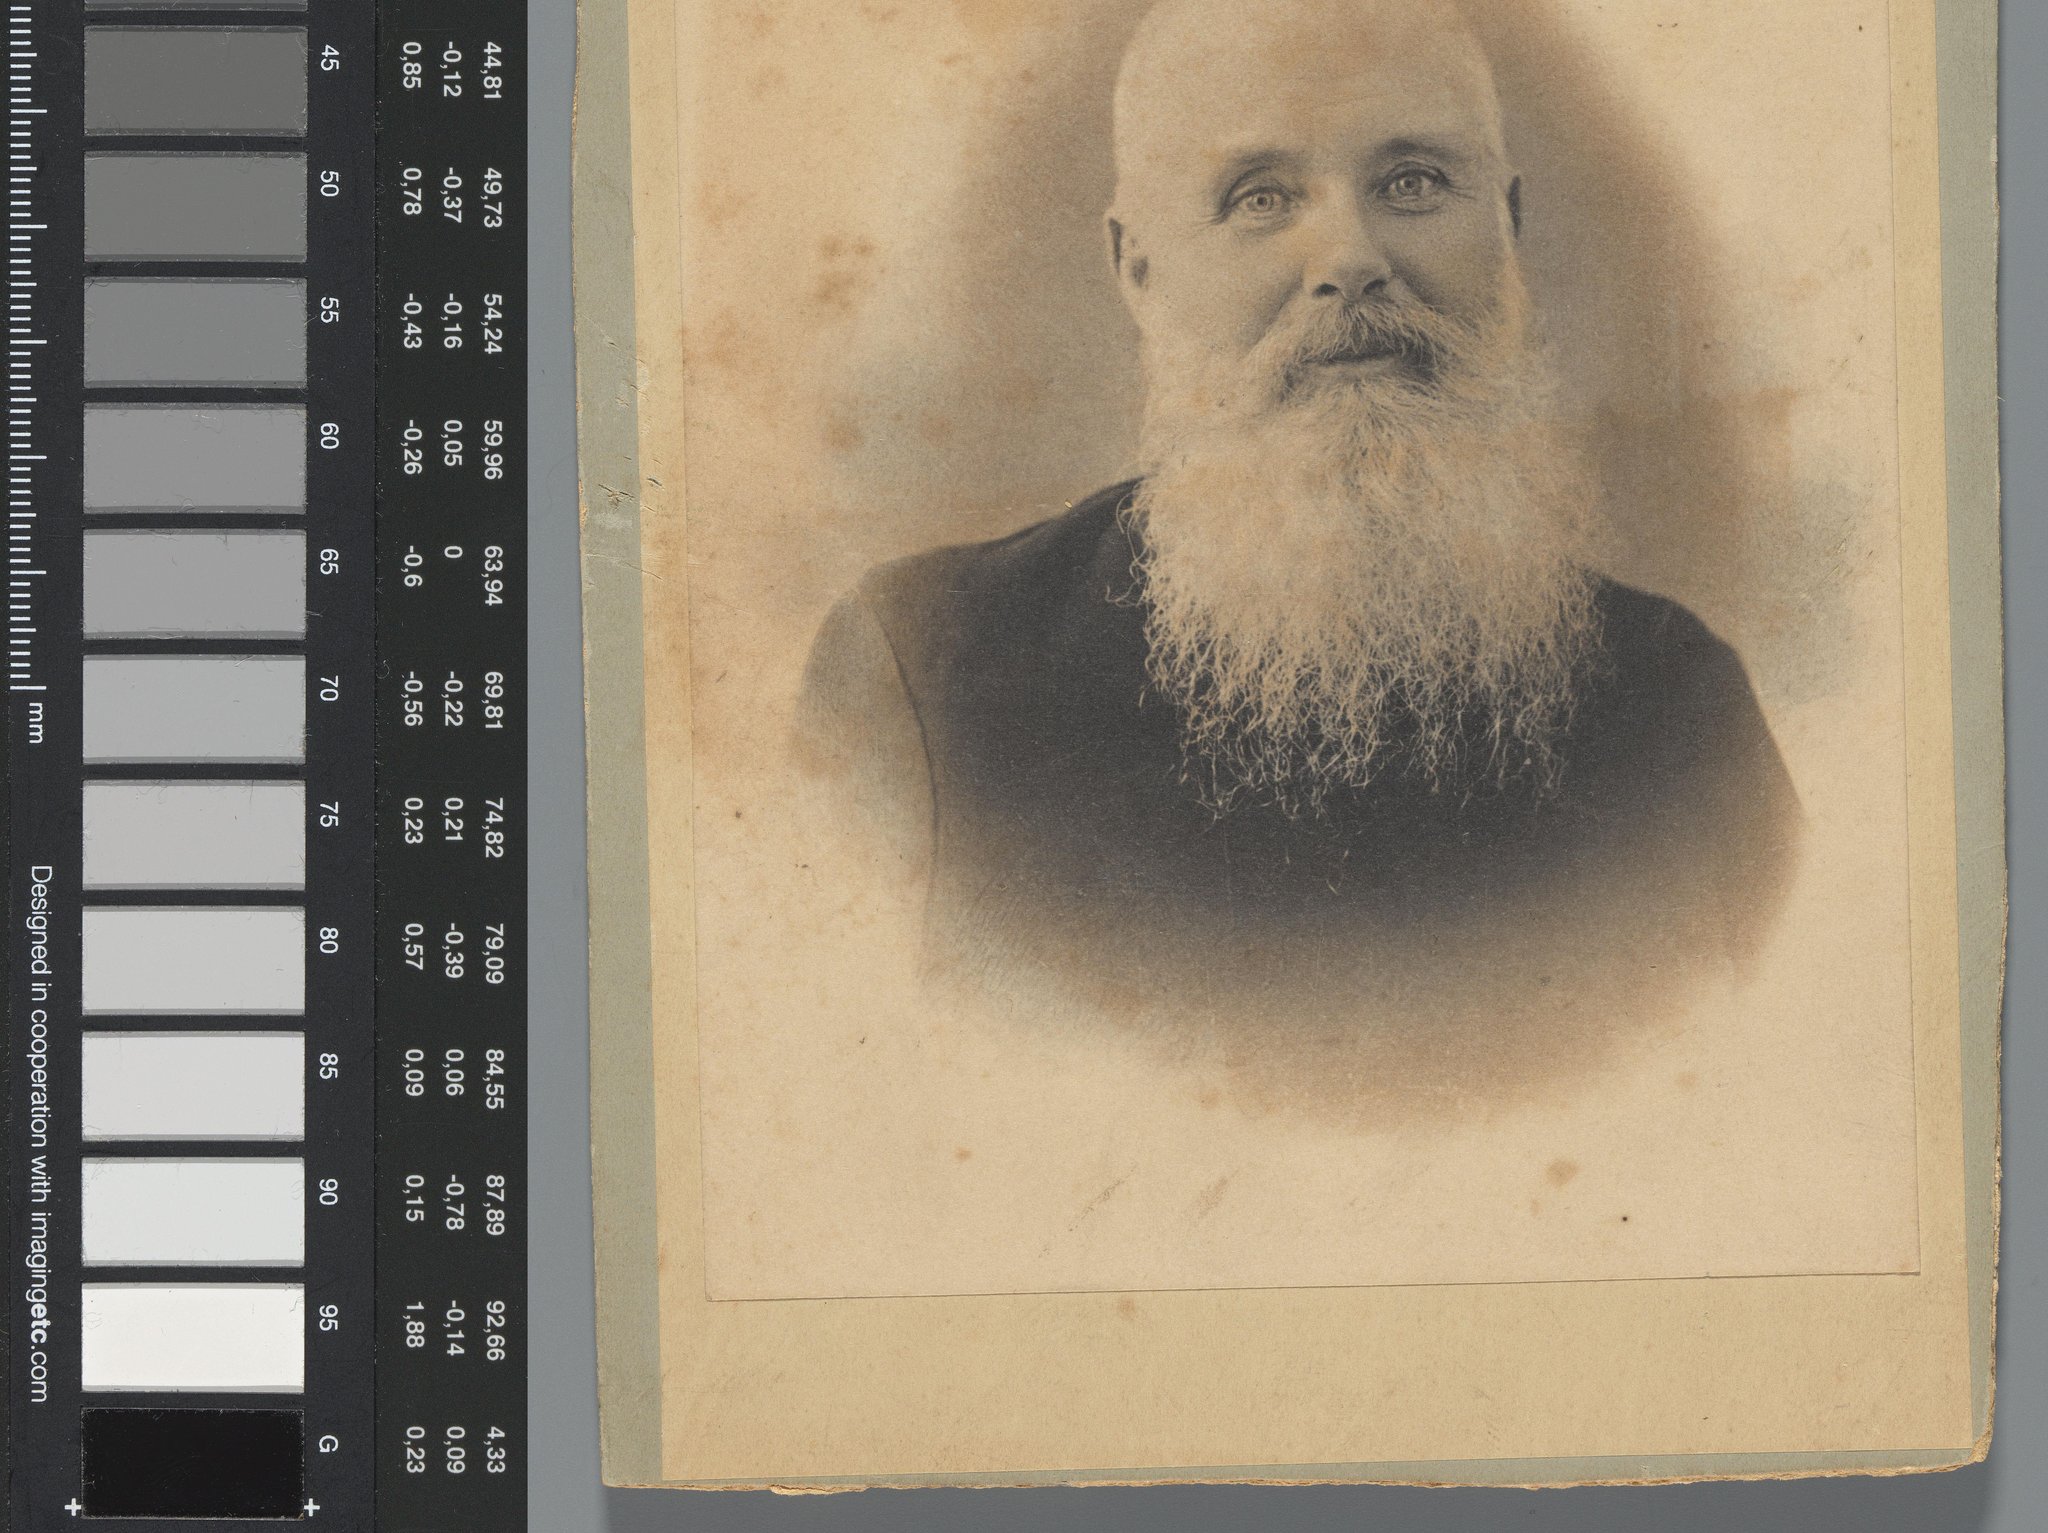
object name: photograph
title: Portret van Karel Fredrik Holle met baard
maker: Anonymous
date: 1855-1910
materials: cardboard, photographic support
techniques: albumen print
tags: amsterdam, historical persons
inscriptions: inscription: ‘Frederik / Oom Karel v Holle / broer van grootmoeder / C.F. van den Berg / Holle’